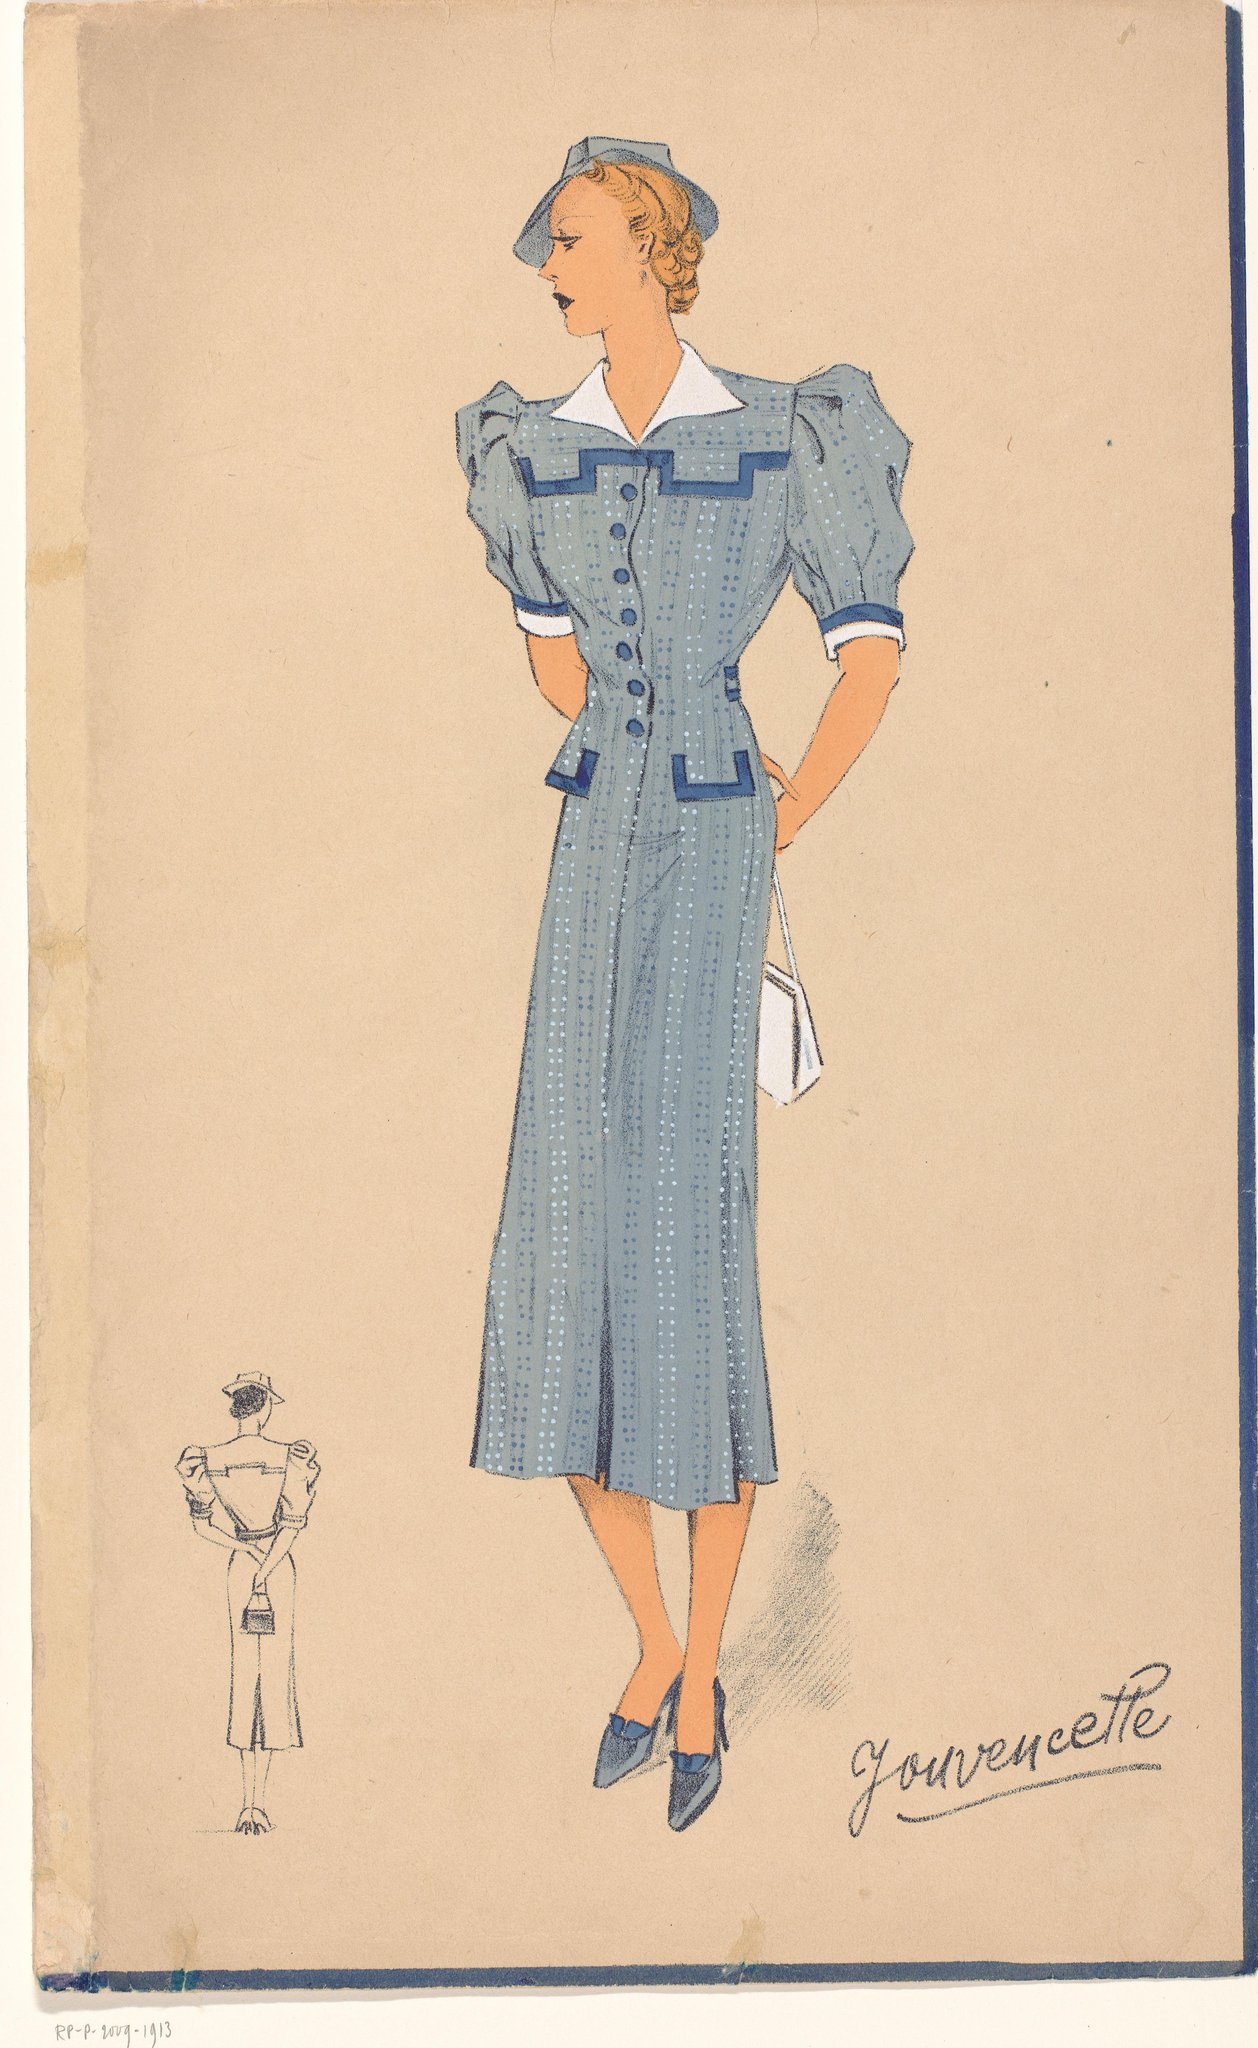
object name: fashion print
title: Vrouw in een blauwe japon met witte kraag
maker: Anonymous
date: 1930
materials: paper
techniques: hand coloring, lithograph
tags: button (+ women's clothes), bag (handbag) (+ women's clothes), fashion plates, head-gear: hat (+ women's clothes), shoes, sandals (+ women's clothes), dress, gown (+ women's clothes)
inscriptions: inscription: ‘Jouvencette’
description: Staande vrouw in een lichtblauwe japon met licht- en donkerblauw verticaal stippenmotief. Witte platte kraag. Middenvoor gesloten middels zeven donkerblauwe knopen. Korte pofmouwen met donkerblauw/witte manchetten. Schuin op het hoofd een lichtblauwe hoed. Witte handtas in de hand. Blauwe schoenen met hakken. Linksonder een lijntekening van de achterkant van de jurk.